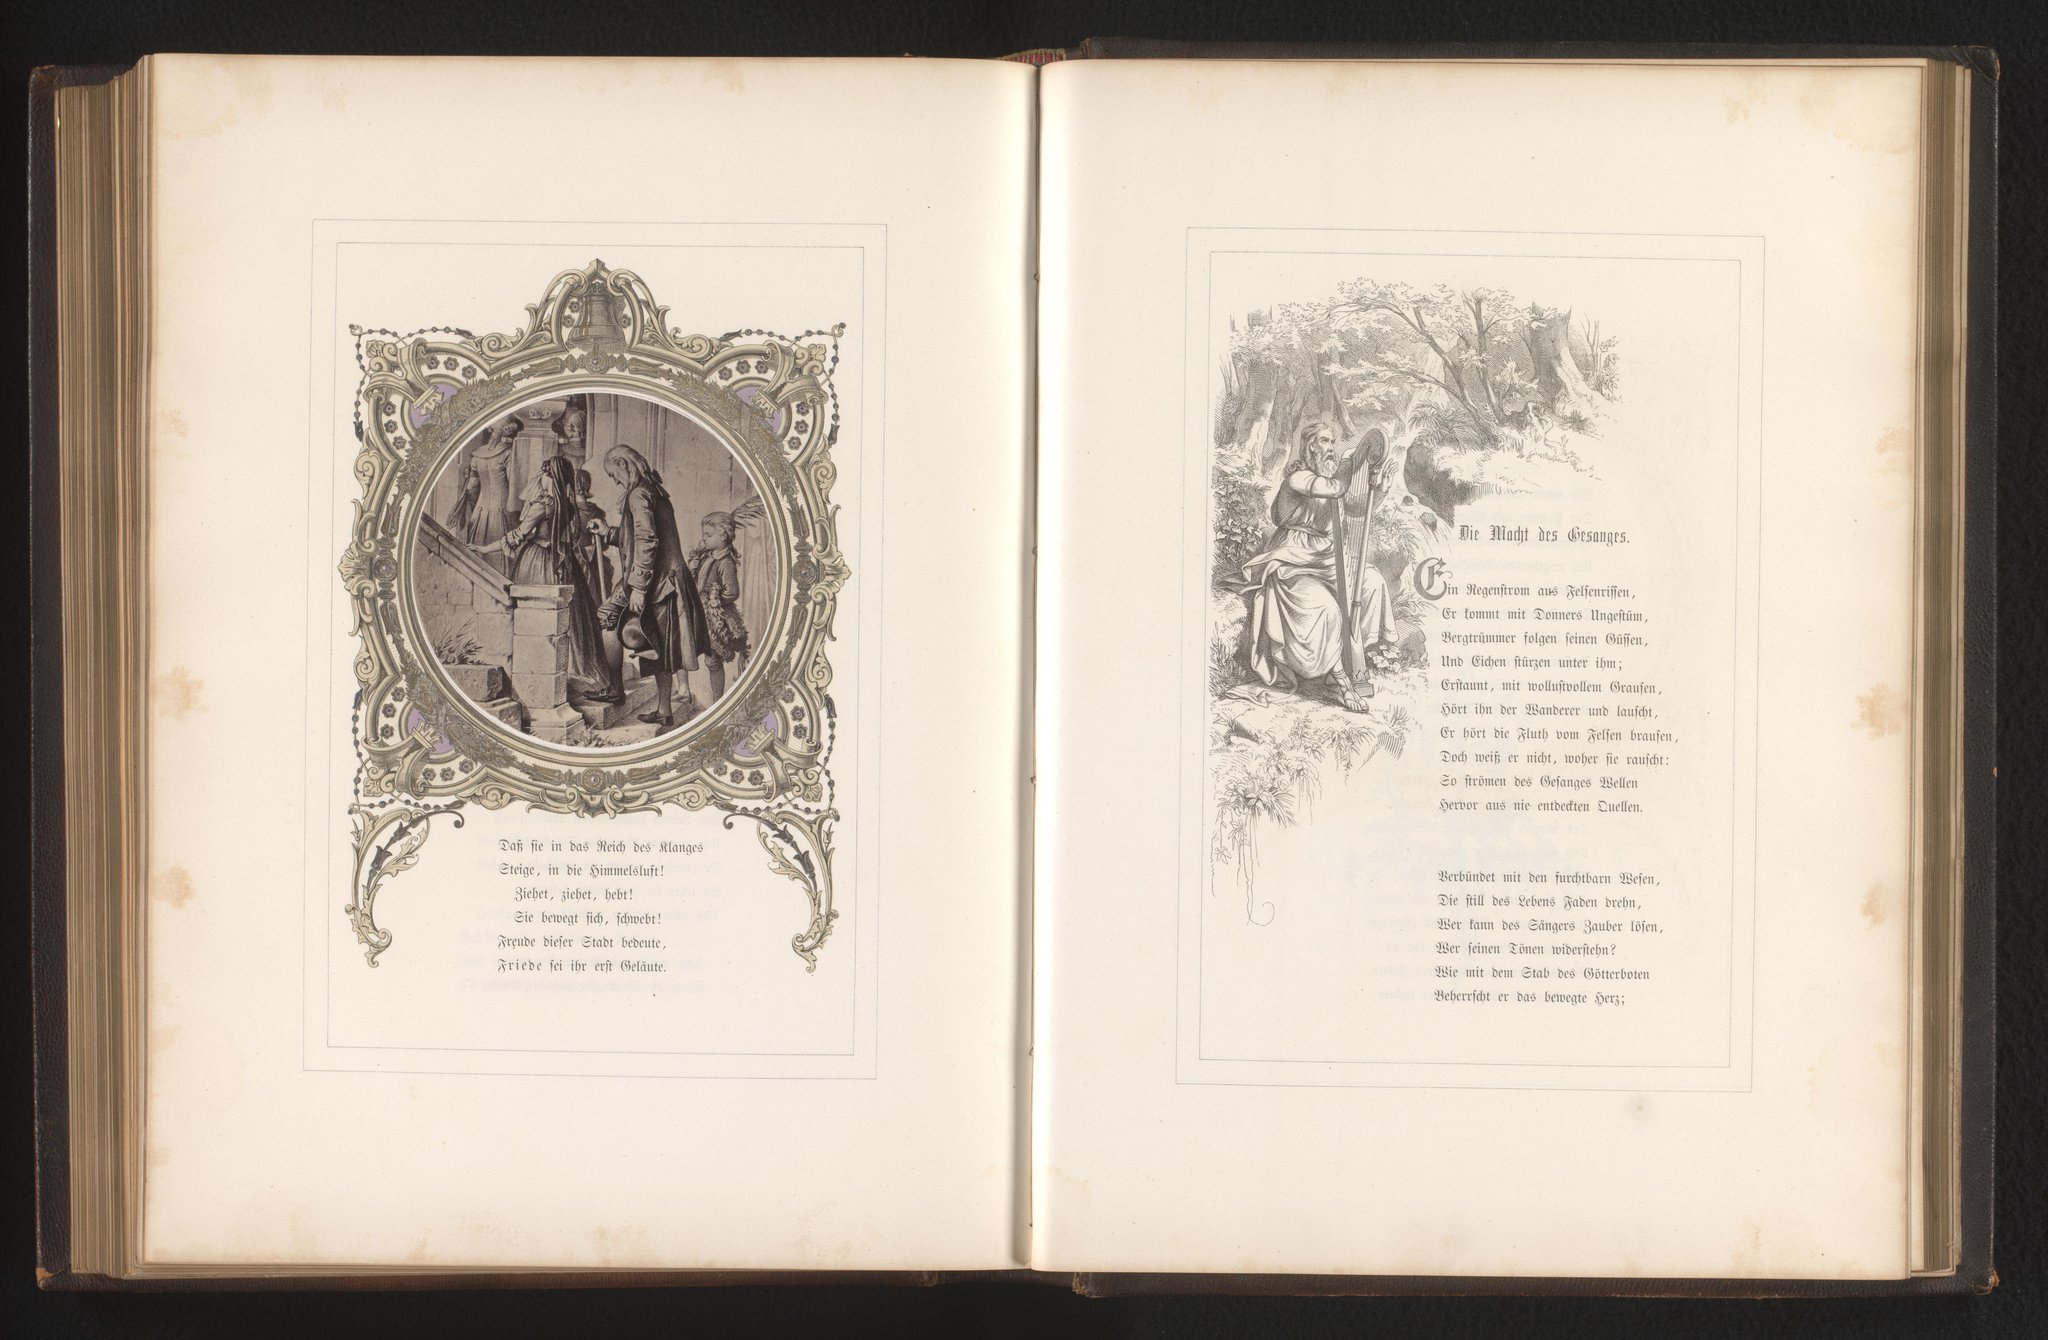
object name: page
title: Ramberg: Das Lied von der Glocke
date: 1855-1862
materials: paper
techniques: albumen print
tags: front steps